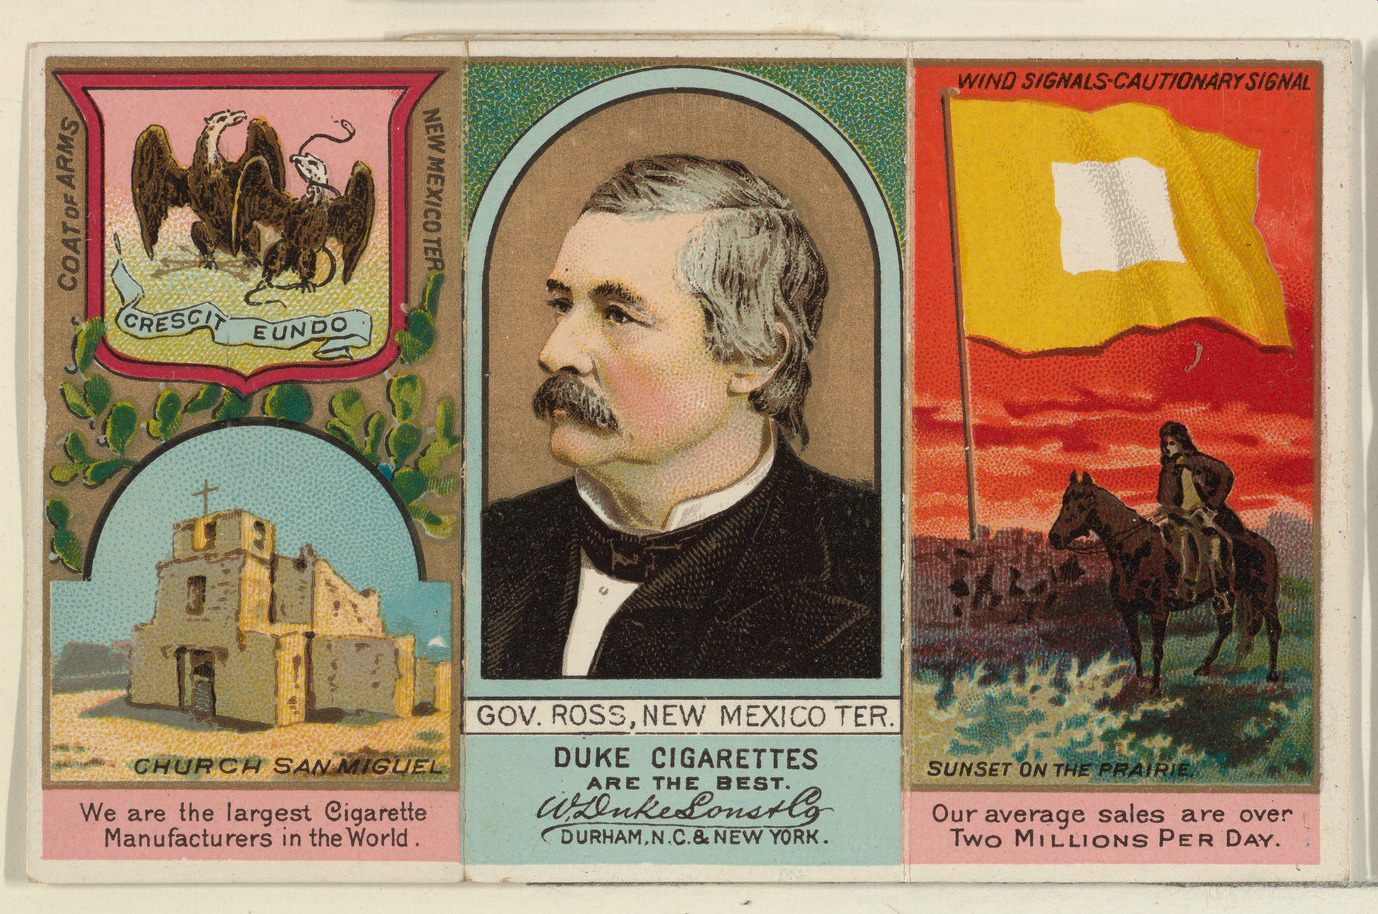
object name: print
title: Governor Ross, New Mexico Territory, from "Governors, Arms, Etc." series (N133-2), issued by Duke Sons & Co.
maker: w. duke, sons & co.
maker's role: publisher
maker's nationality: american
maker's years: 1870-1920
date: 1888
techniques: color lithograph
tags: men,profiles,coat of arms,flags